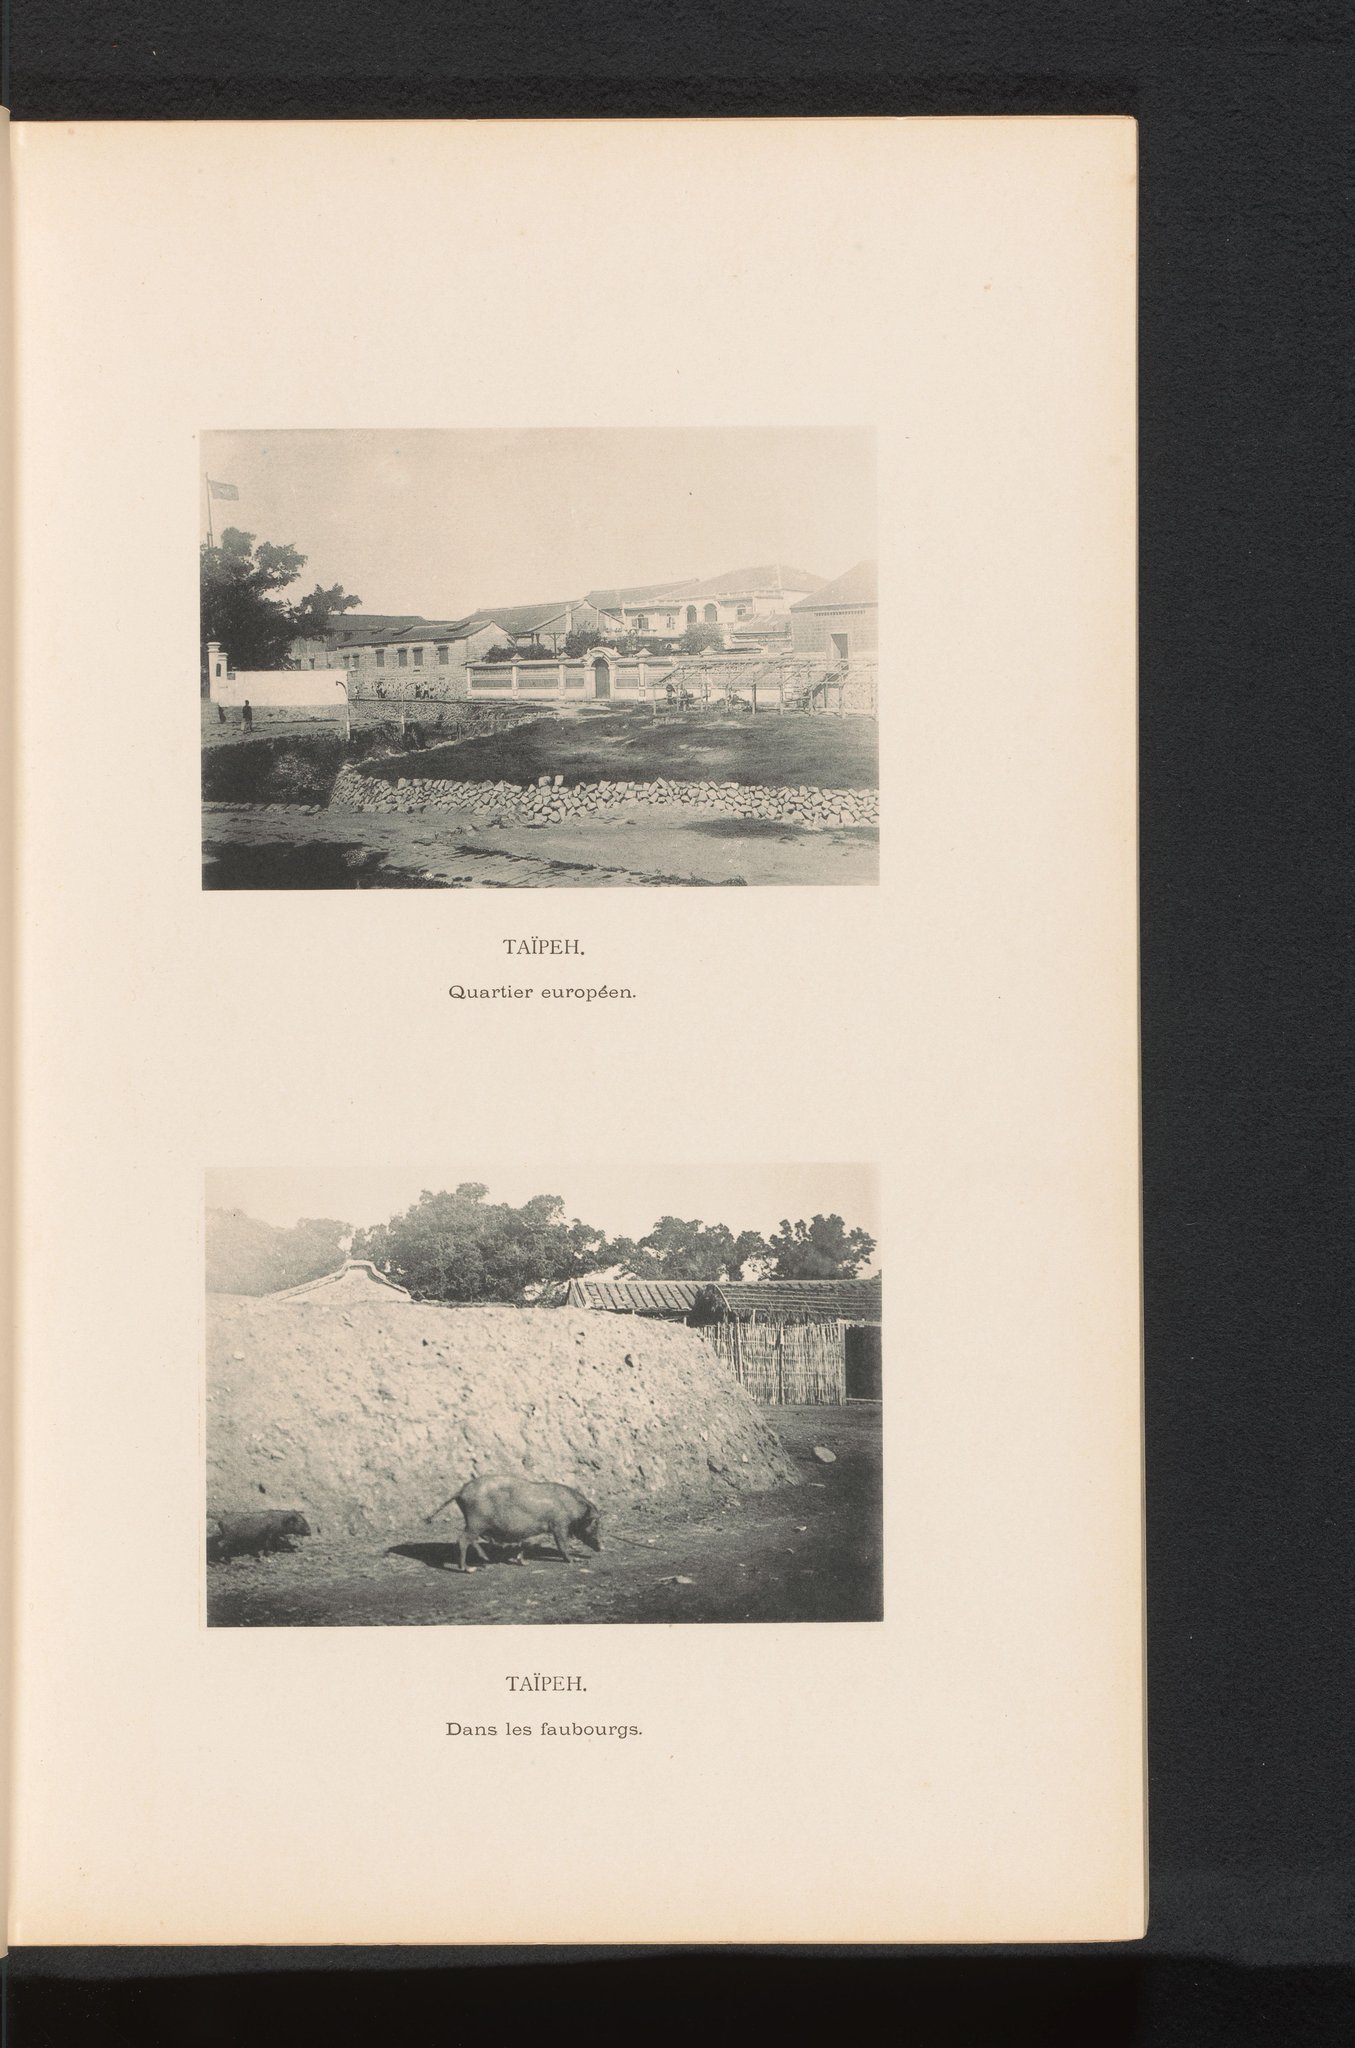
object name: photomechanical print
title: Gezicht op een Europese nederzetting en een buitenwijk in Taipei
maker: Anonymous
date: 1891-1896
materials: paper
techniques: photograph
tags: urban housing, pig, rural housing, e.g. country-house, villa, cottage